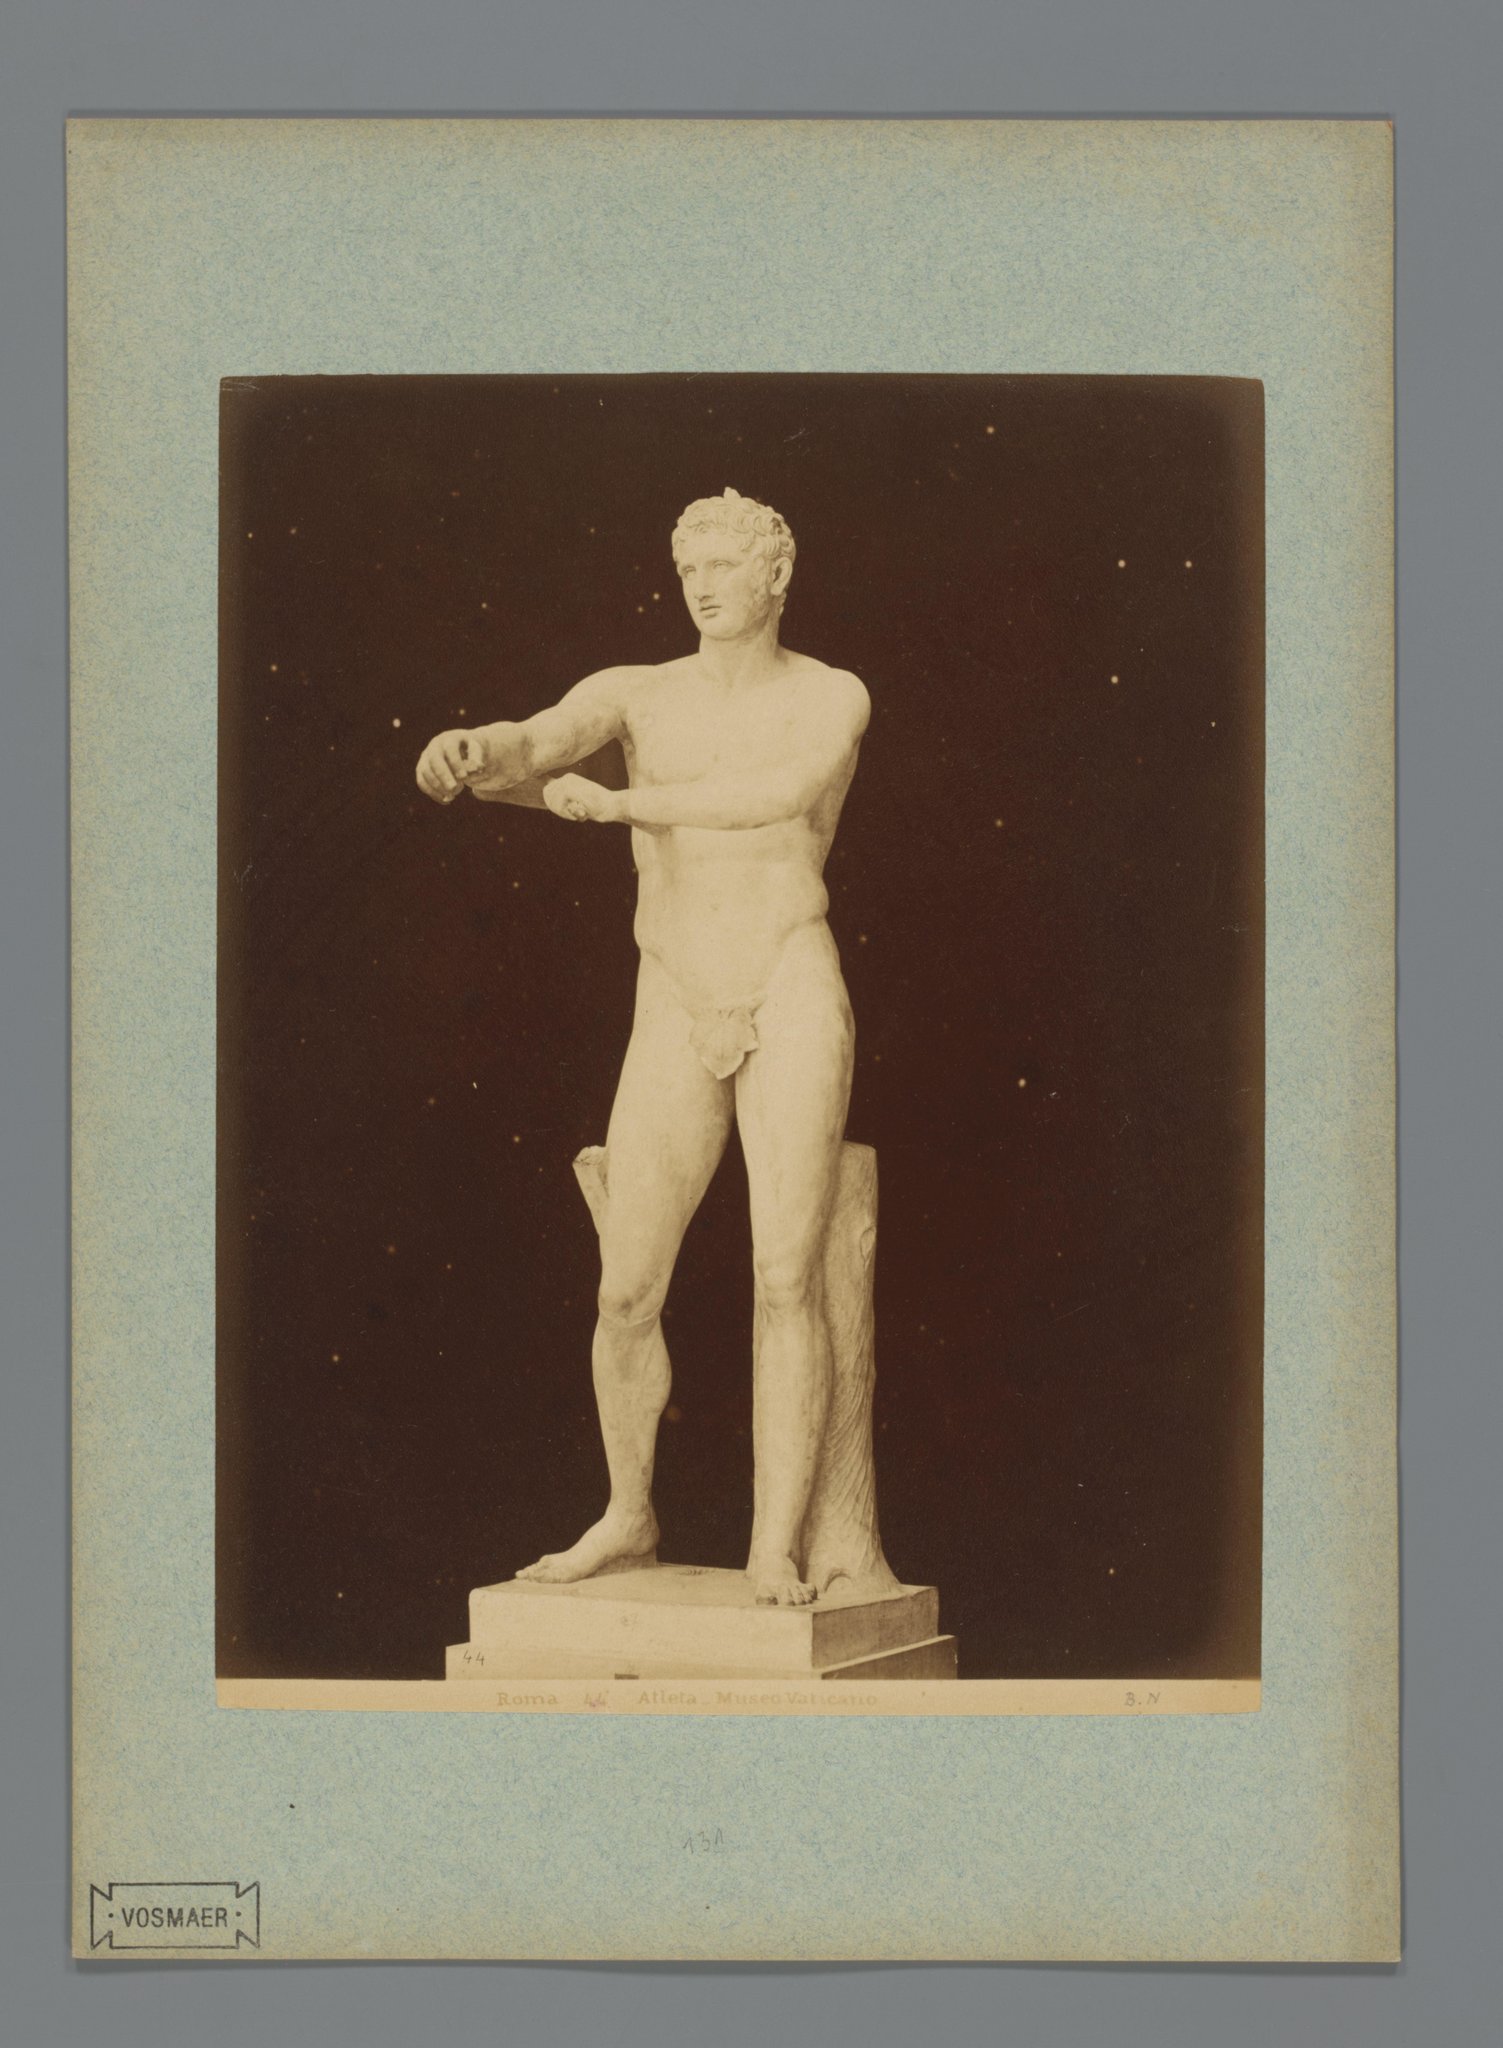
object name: photograph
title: Apoxyomenos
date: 1851-1900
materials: cardboard, paper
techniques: albumen print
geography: vatican city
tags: monument, statue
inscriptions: number: ‘44.’, inscription: ‘B.N’, collector's mark: ‘VOSMAER’